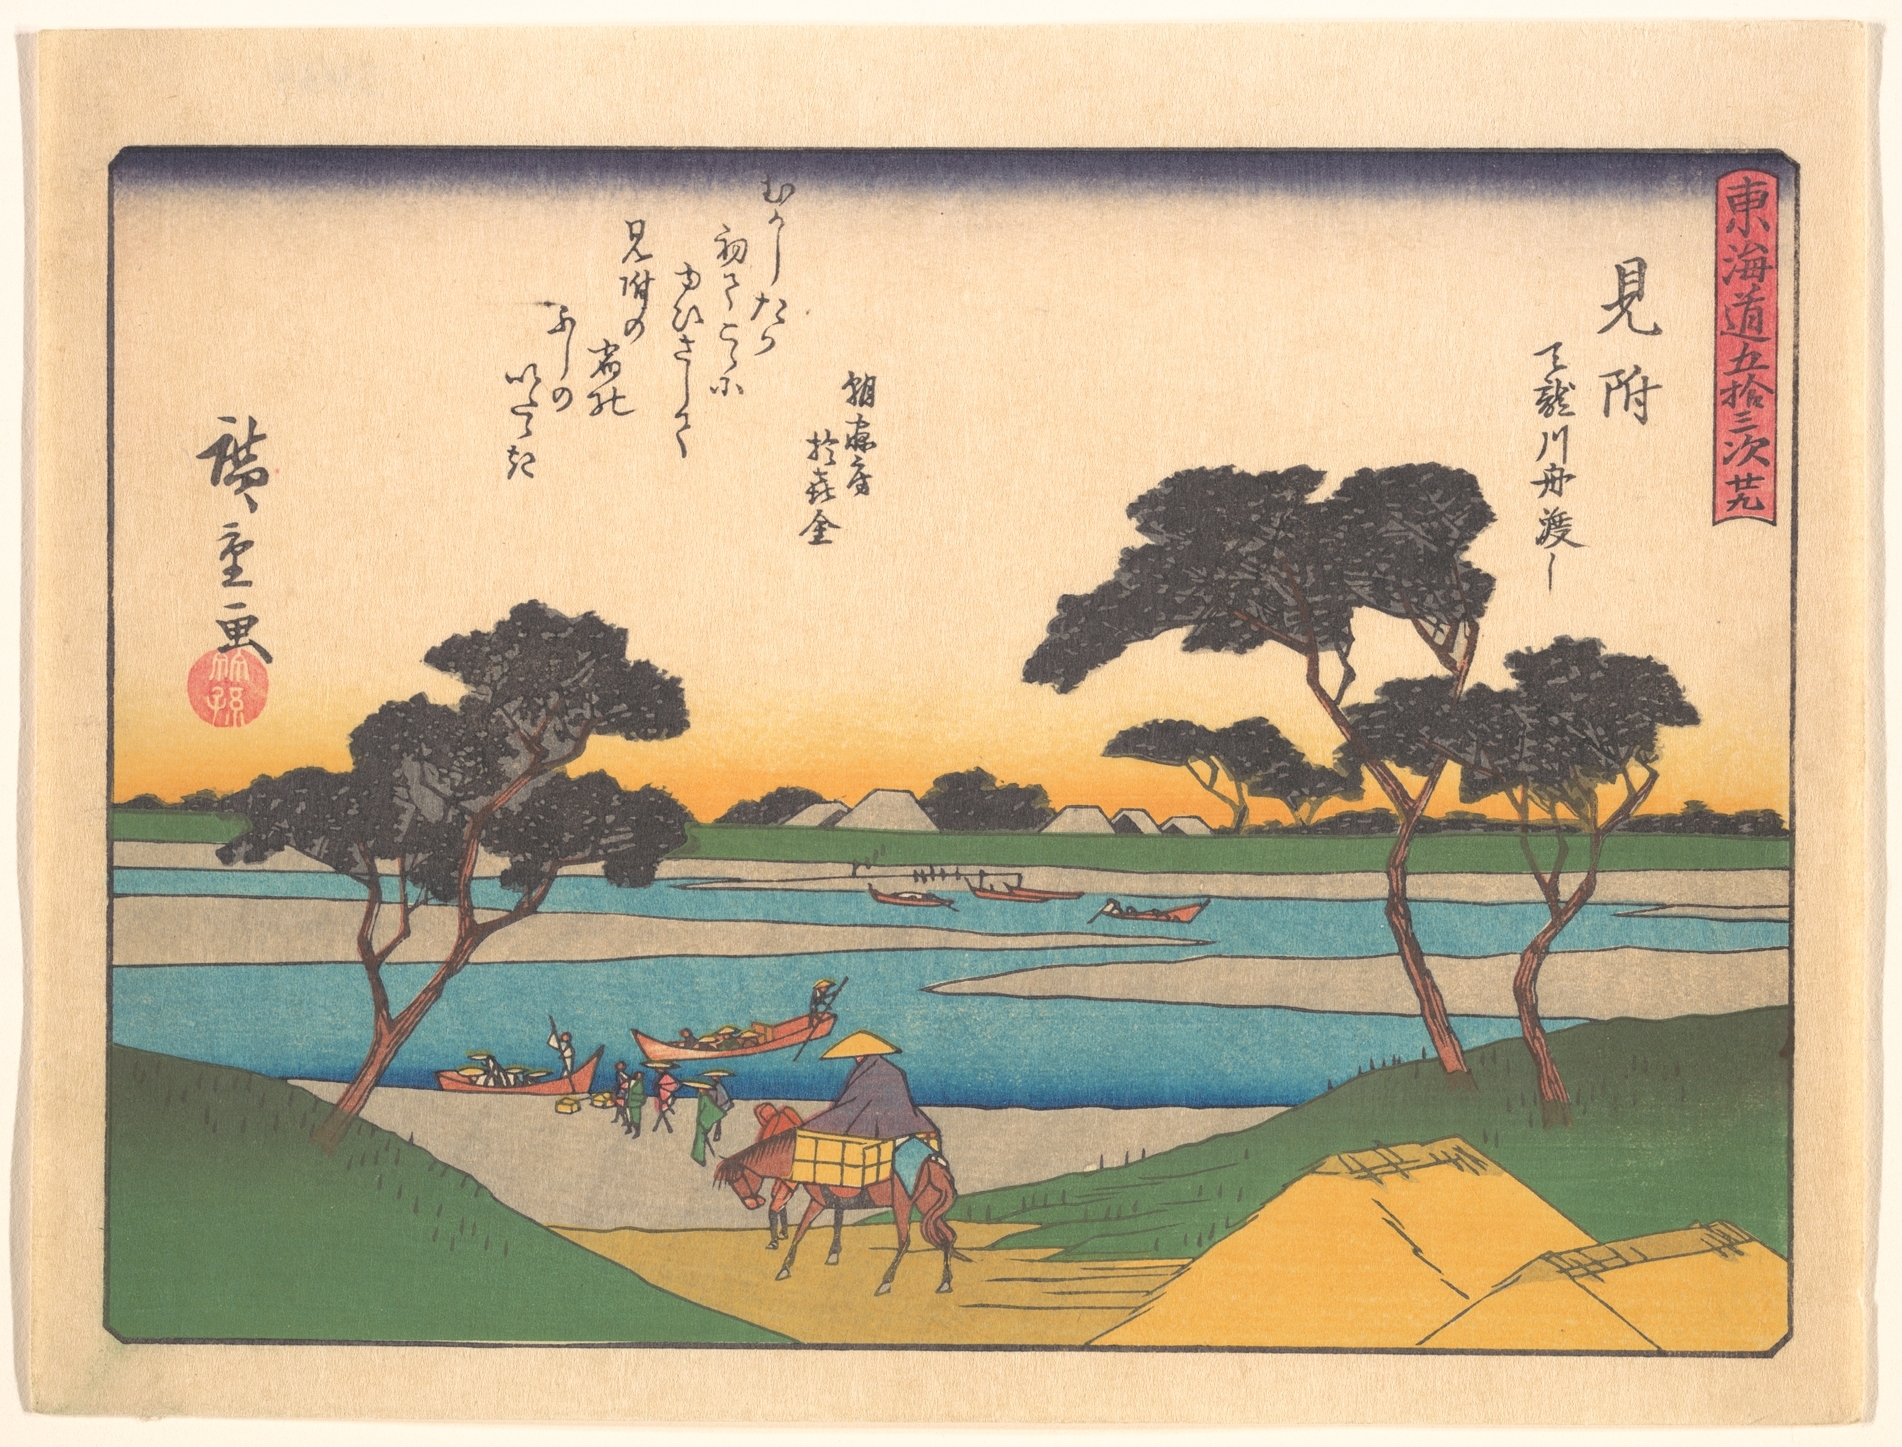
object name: print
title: 東海道五十三次 見附 天竜川舟渡し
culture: japanese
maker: utagawa hiroshige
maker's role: artist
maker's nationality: japanese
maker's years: 1797-1858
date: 1901-1933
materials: ink, paper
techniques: woodblock print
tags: horses,landscapes,trees,boats